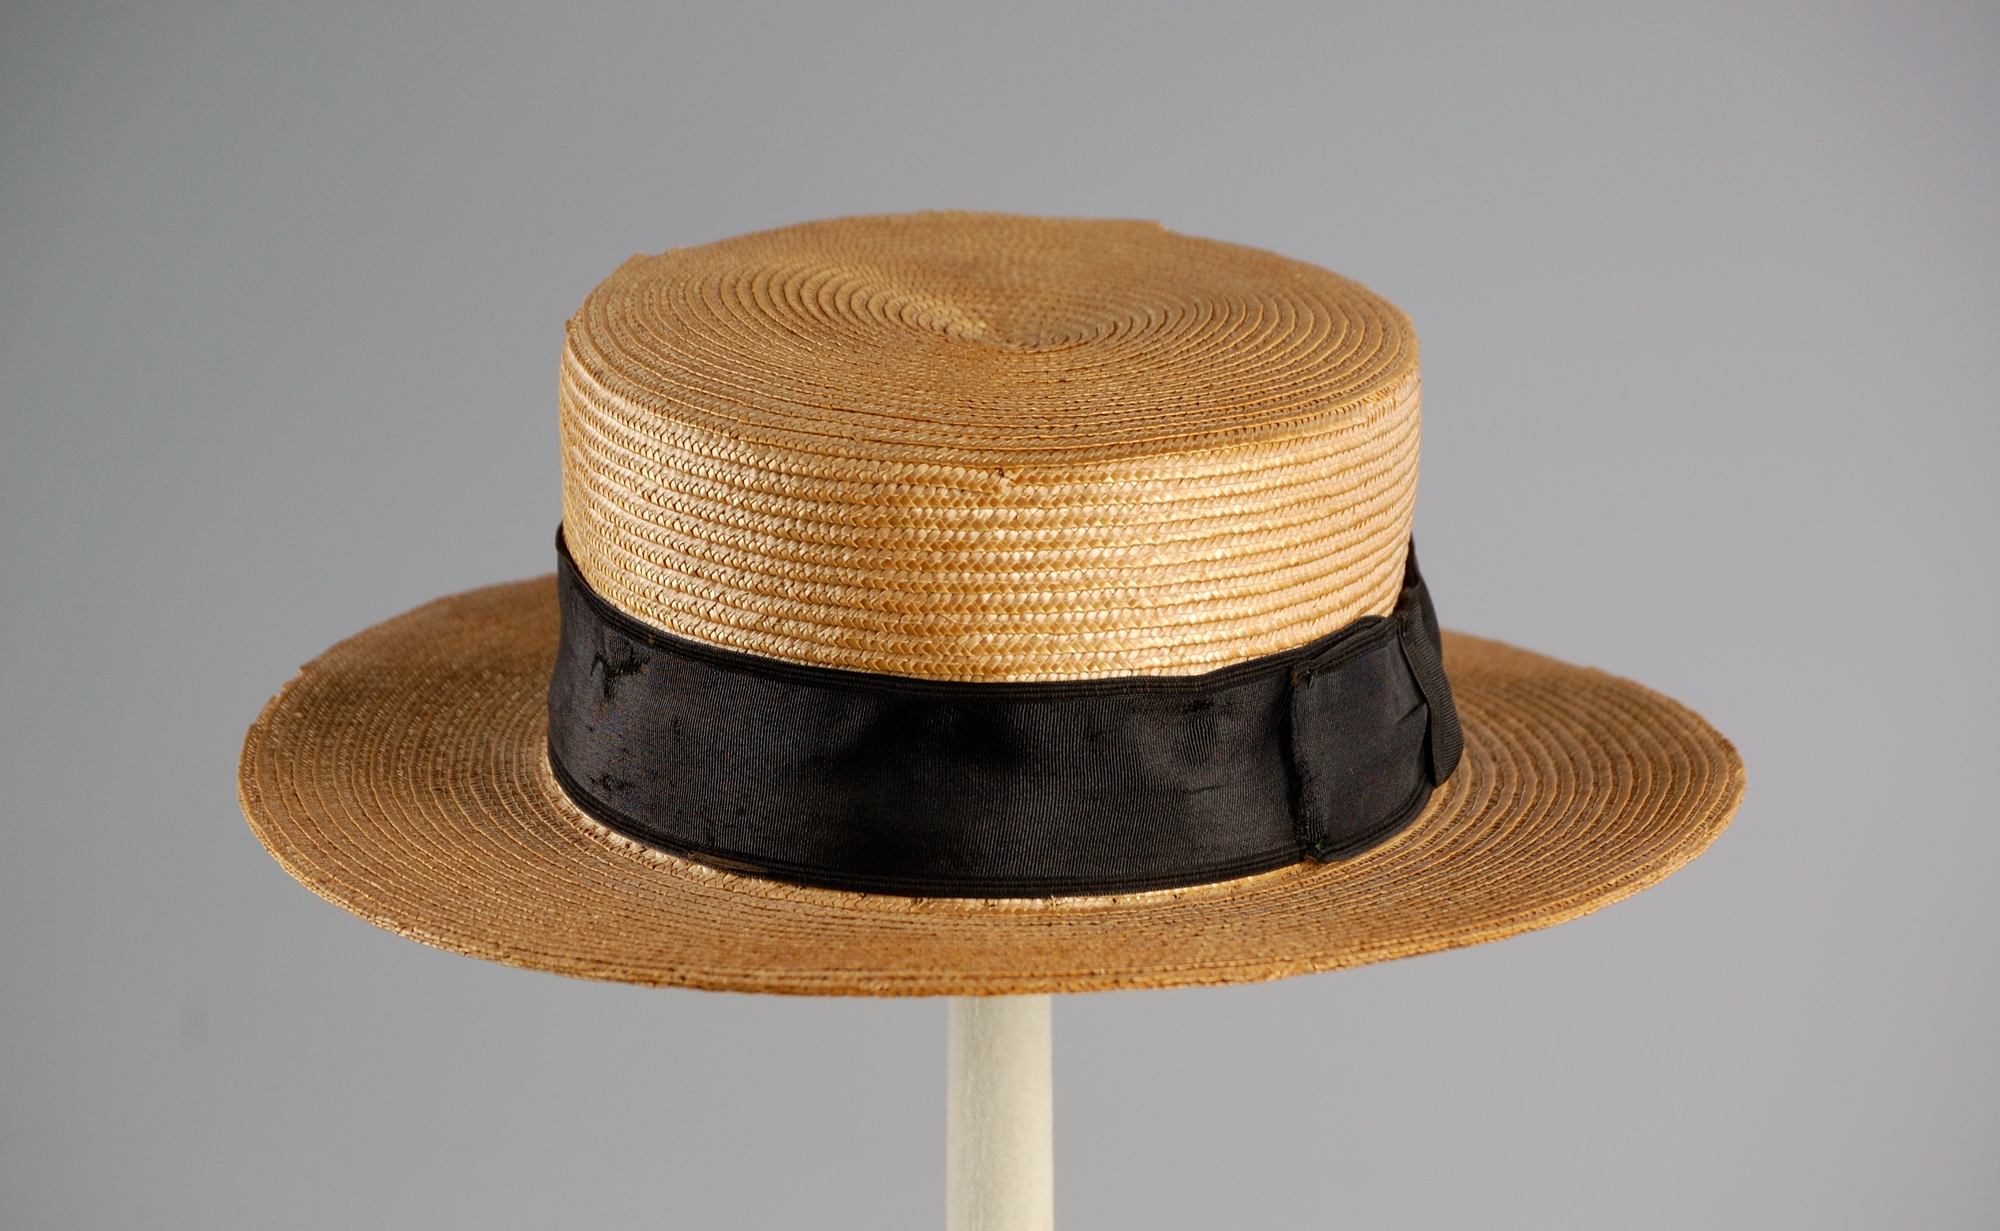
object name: boater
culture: american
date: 1890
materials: silk, fiber